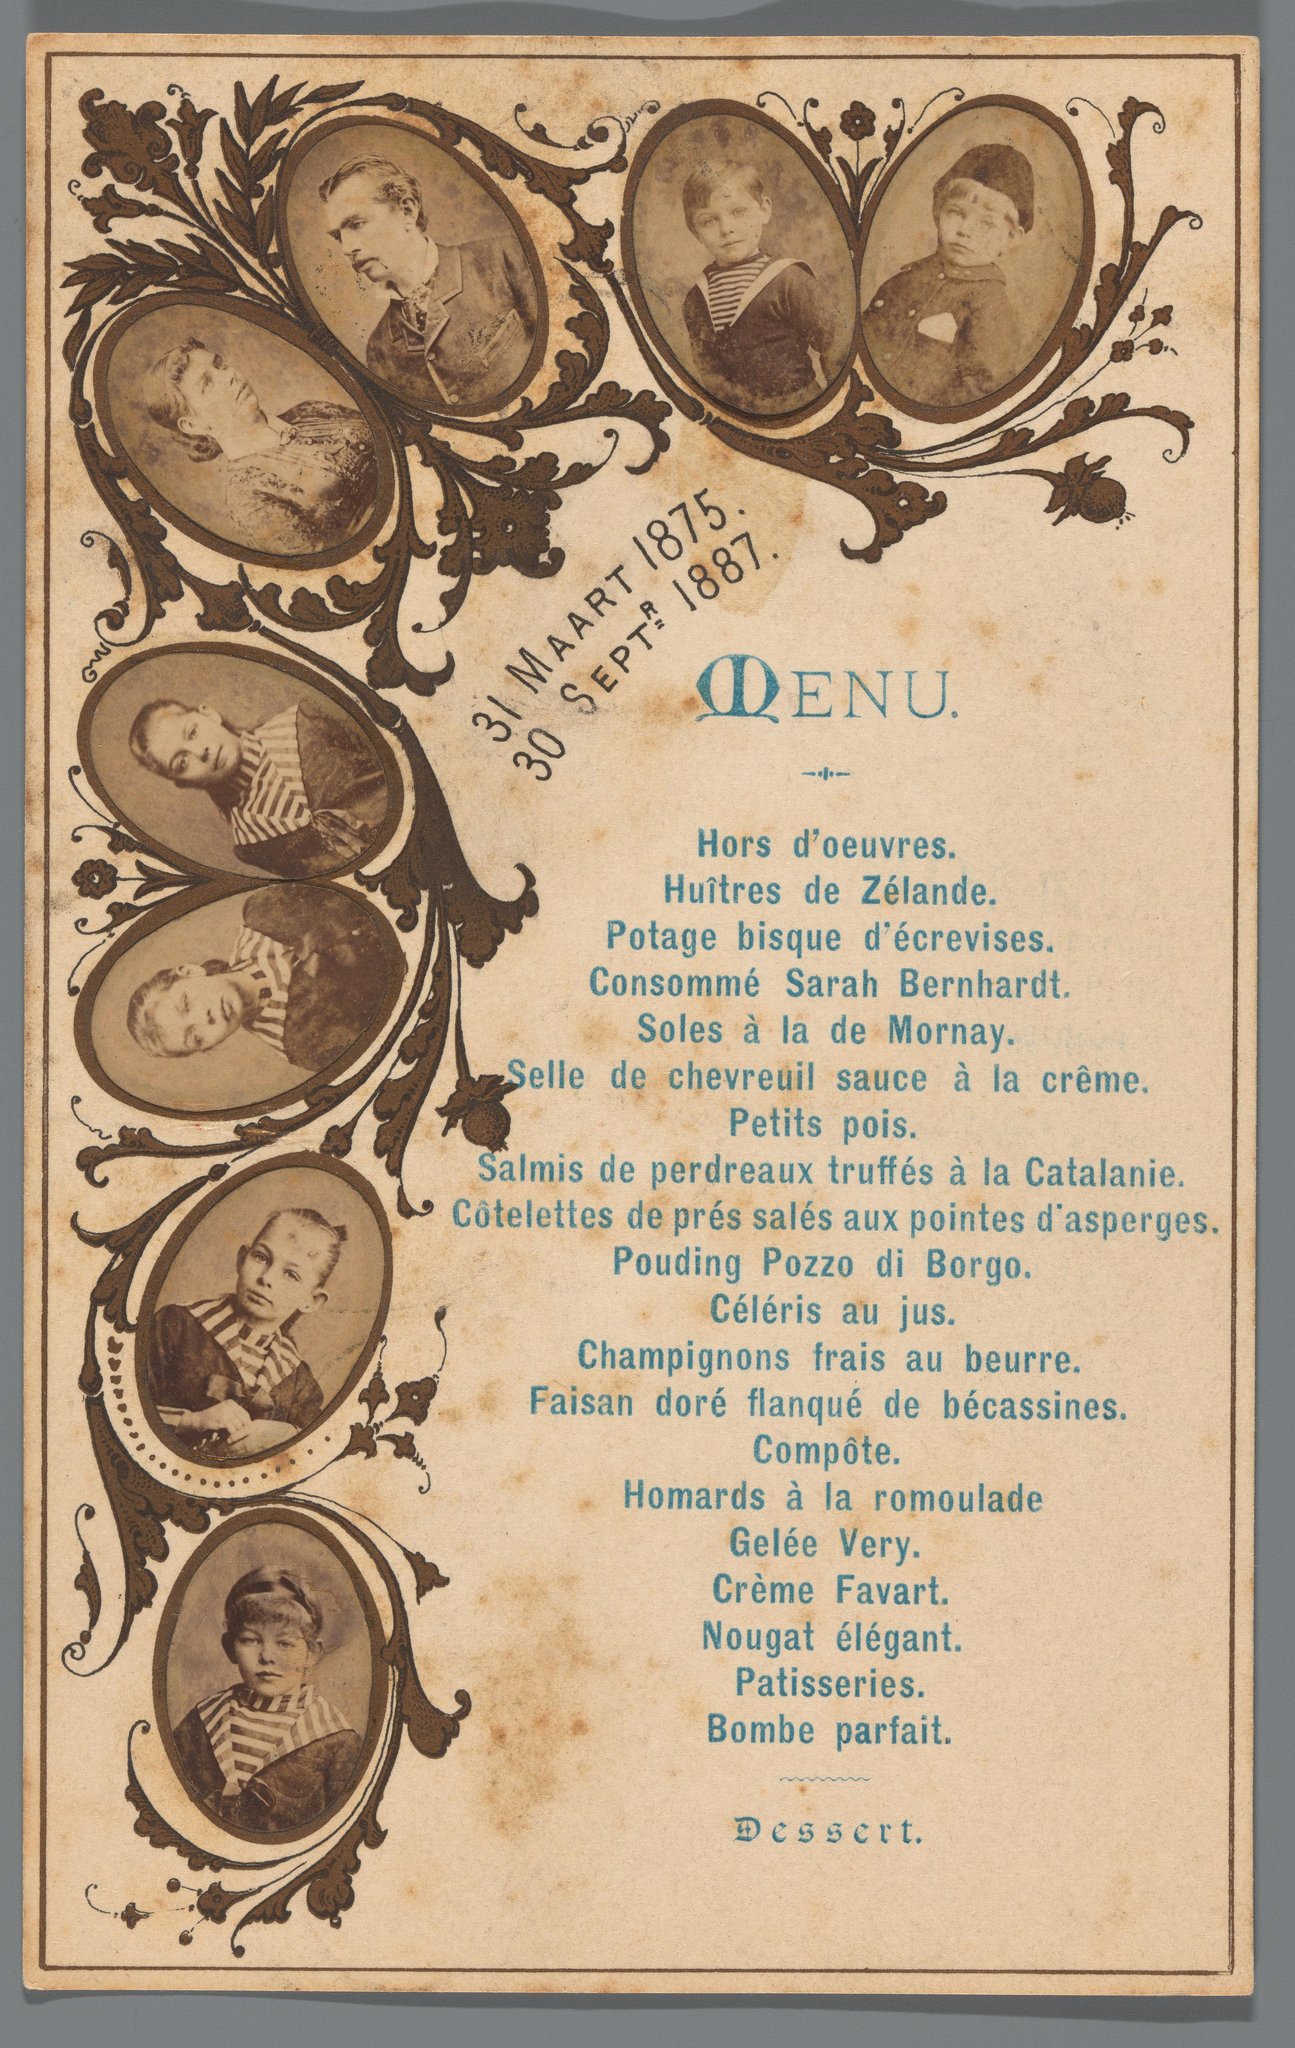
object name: photograph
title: Menukaart met 8 ovale fotoportretten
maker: Anonymous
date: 1887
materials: cardboard, photographic support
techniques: albumen print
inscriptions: inscription: ‘tante Dien’